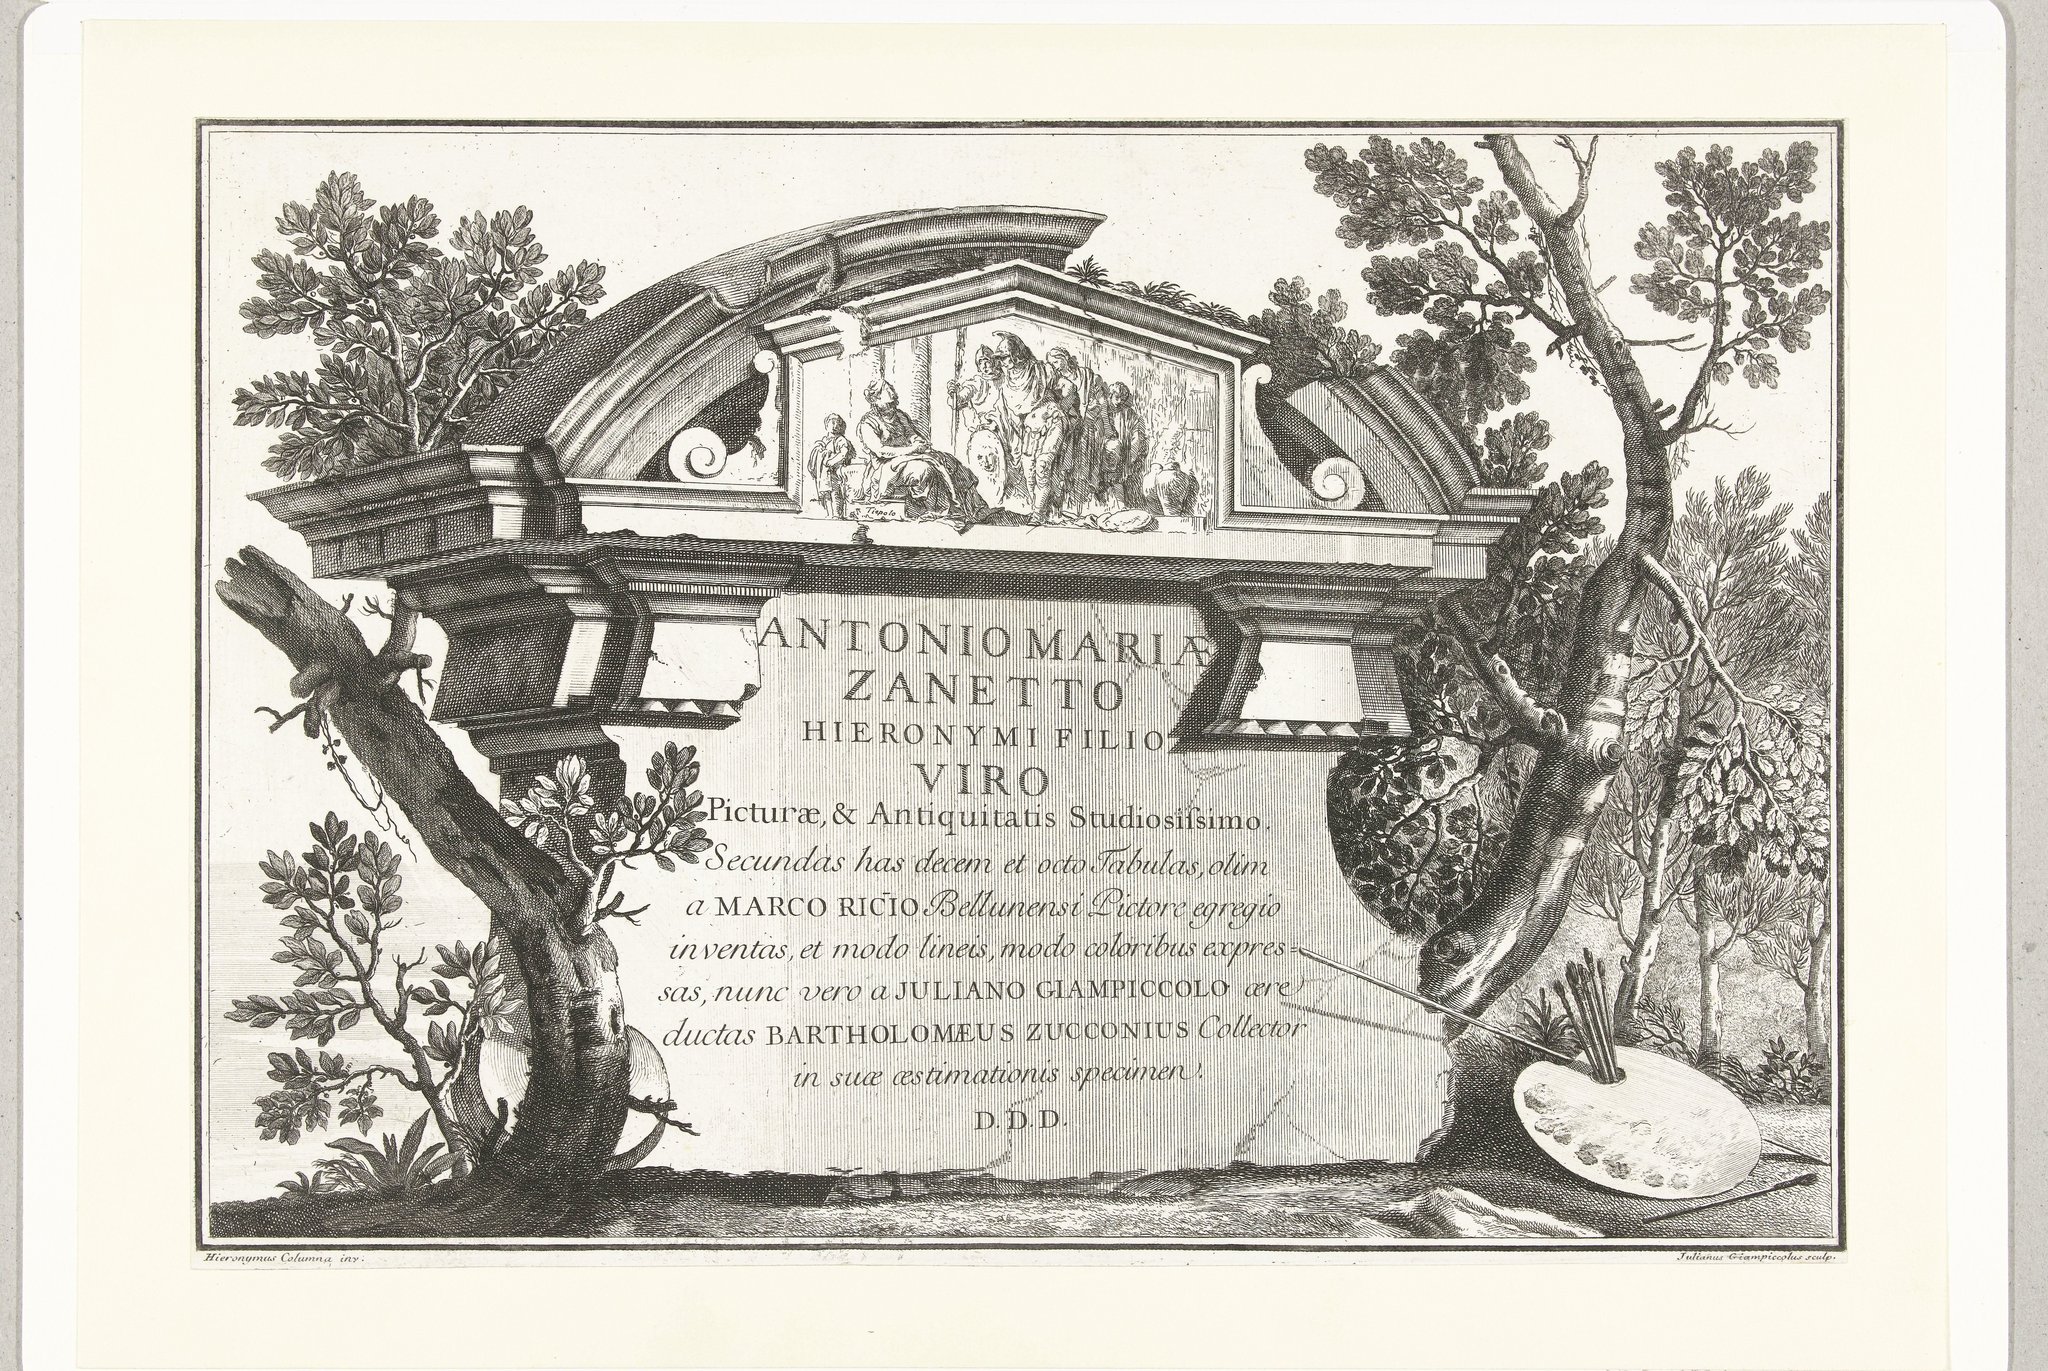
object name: print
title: Landschap met grafmonument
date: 1739-1740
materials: paper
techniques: engraving, etching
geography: venice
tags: landscape with monument, grave-building, monumental tomb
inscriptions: collector's mark: Lugt 2228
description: Titelprent voor tweede deel van serie Italiaanse landschappen met achttien prenten naar ontwerp van Marco Ricci. De naam van Giovanni Battista Tiepolo wordt genoemd op de titelprent van het eerste deel en zijn bijdrage aan de series prenten is lange tijd stof voor discussie geweest. Rizzi gaat er vanuit dat Tiepolo slechts de voorstelling etste op het bas-reliëf op het tympaan van het grafmonument. Daaronder staat Tiepolo's naam vermeld. De titelprent voor het eerste deel toont een vergelijkbaar monument met bijdrage van Tiepolo (vergelijk RP-P-1952-20, zie Rizzi 1971, p. 430). De series in de collectie van het RMA tonen de eerste staat voor vermelding van de uitgever Teodoro Viero bij de tweede uitgave.